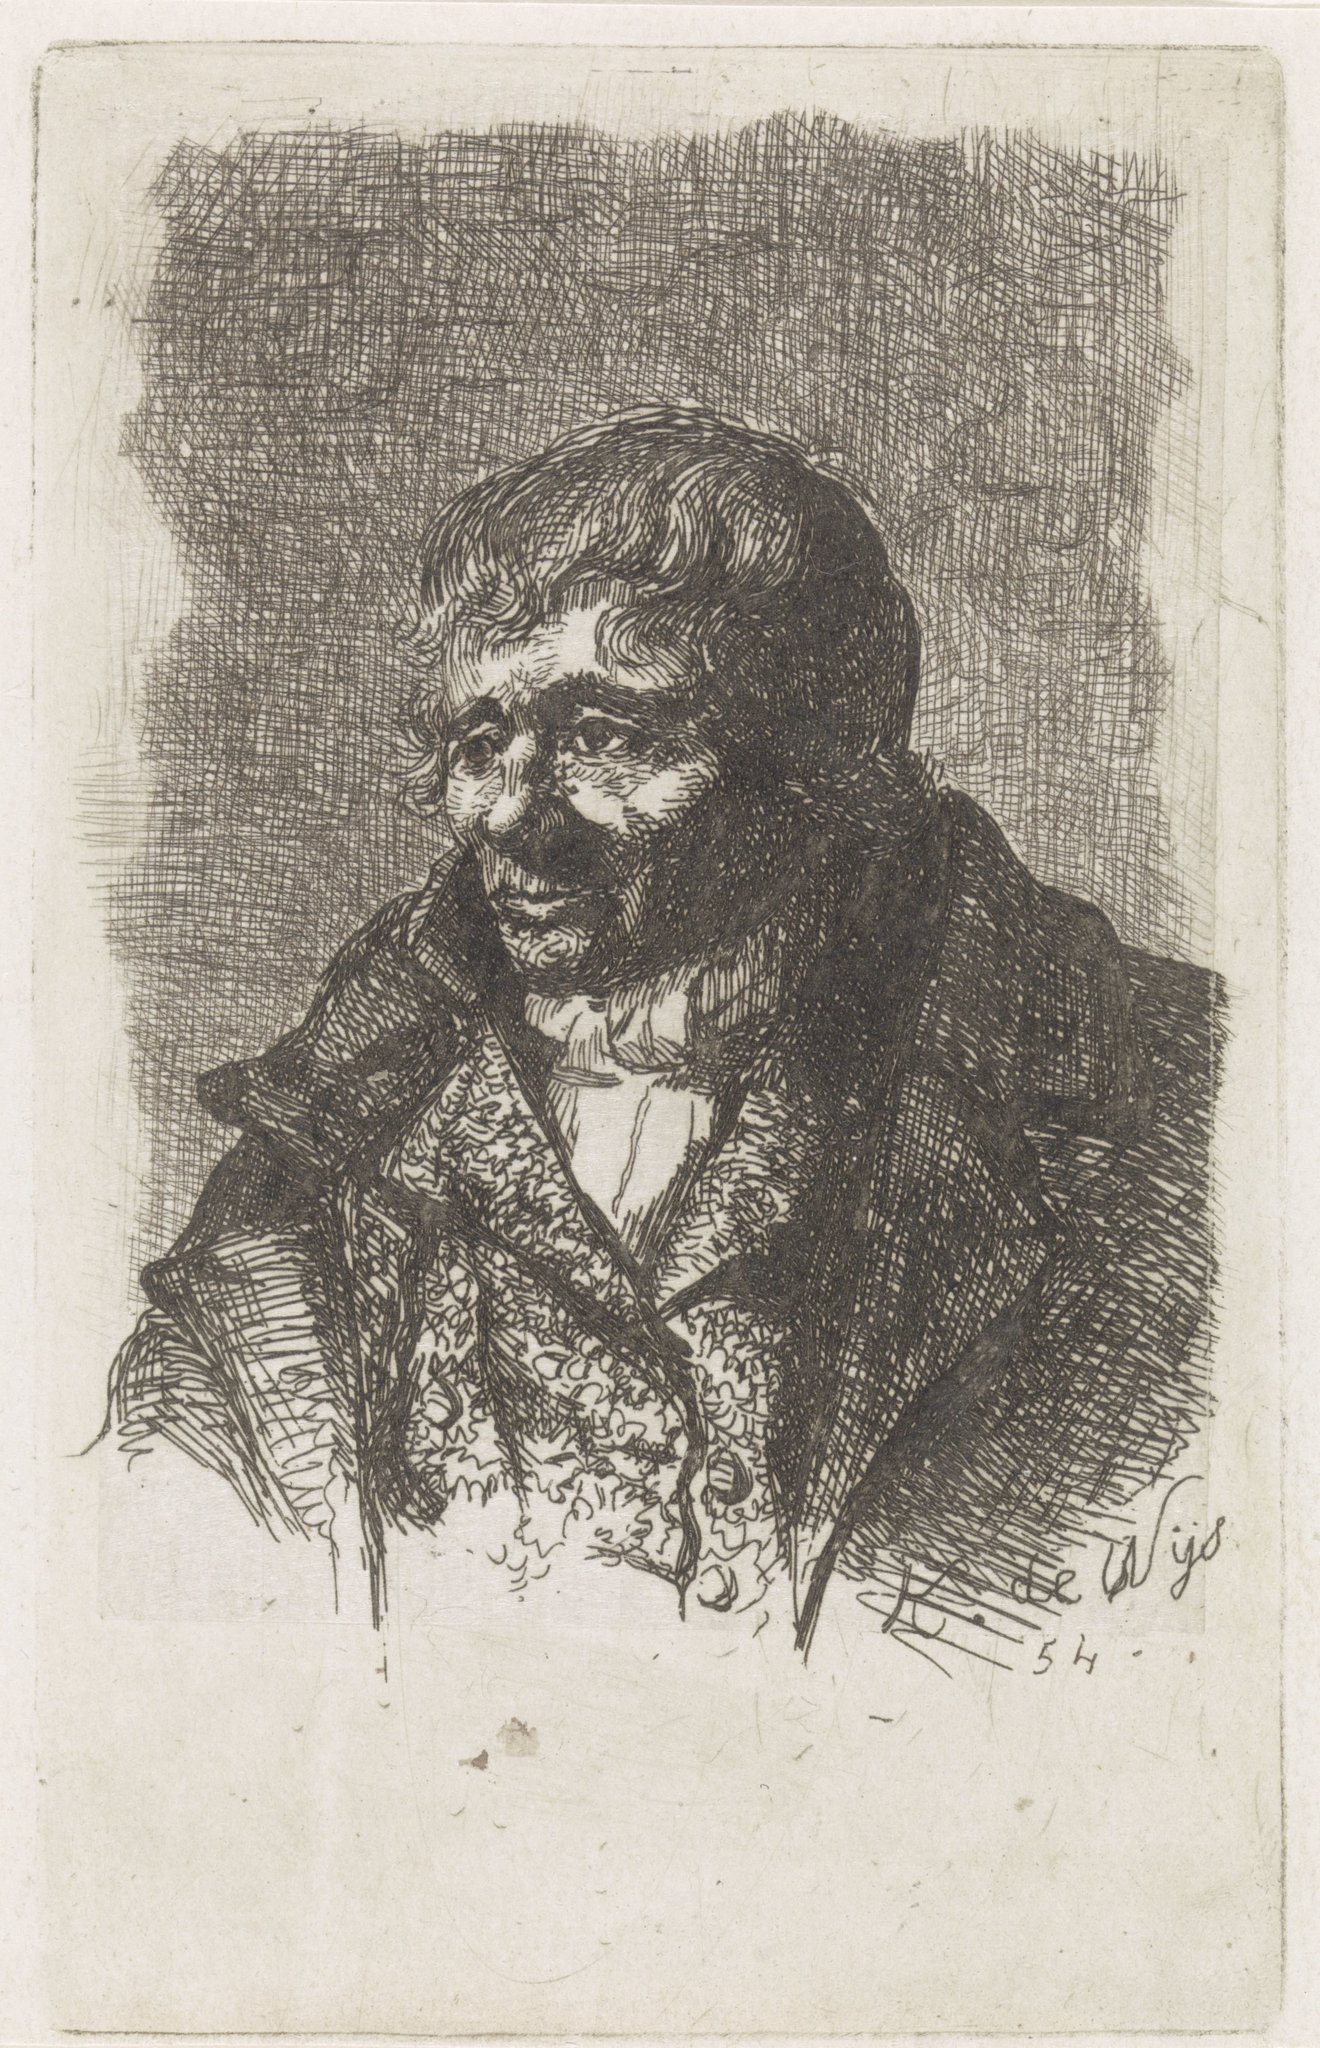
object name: print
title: Buste van een man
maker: kornelis jzn de wijs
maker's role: print maker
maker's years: 1832-1896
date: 1854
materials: paper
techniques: etching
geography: the hague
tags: anonymous historical person portrayed alone (+ (full) bust portrait)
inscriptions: collector's mark: Lugt 2228